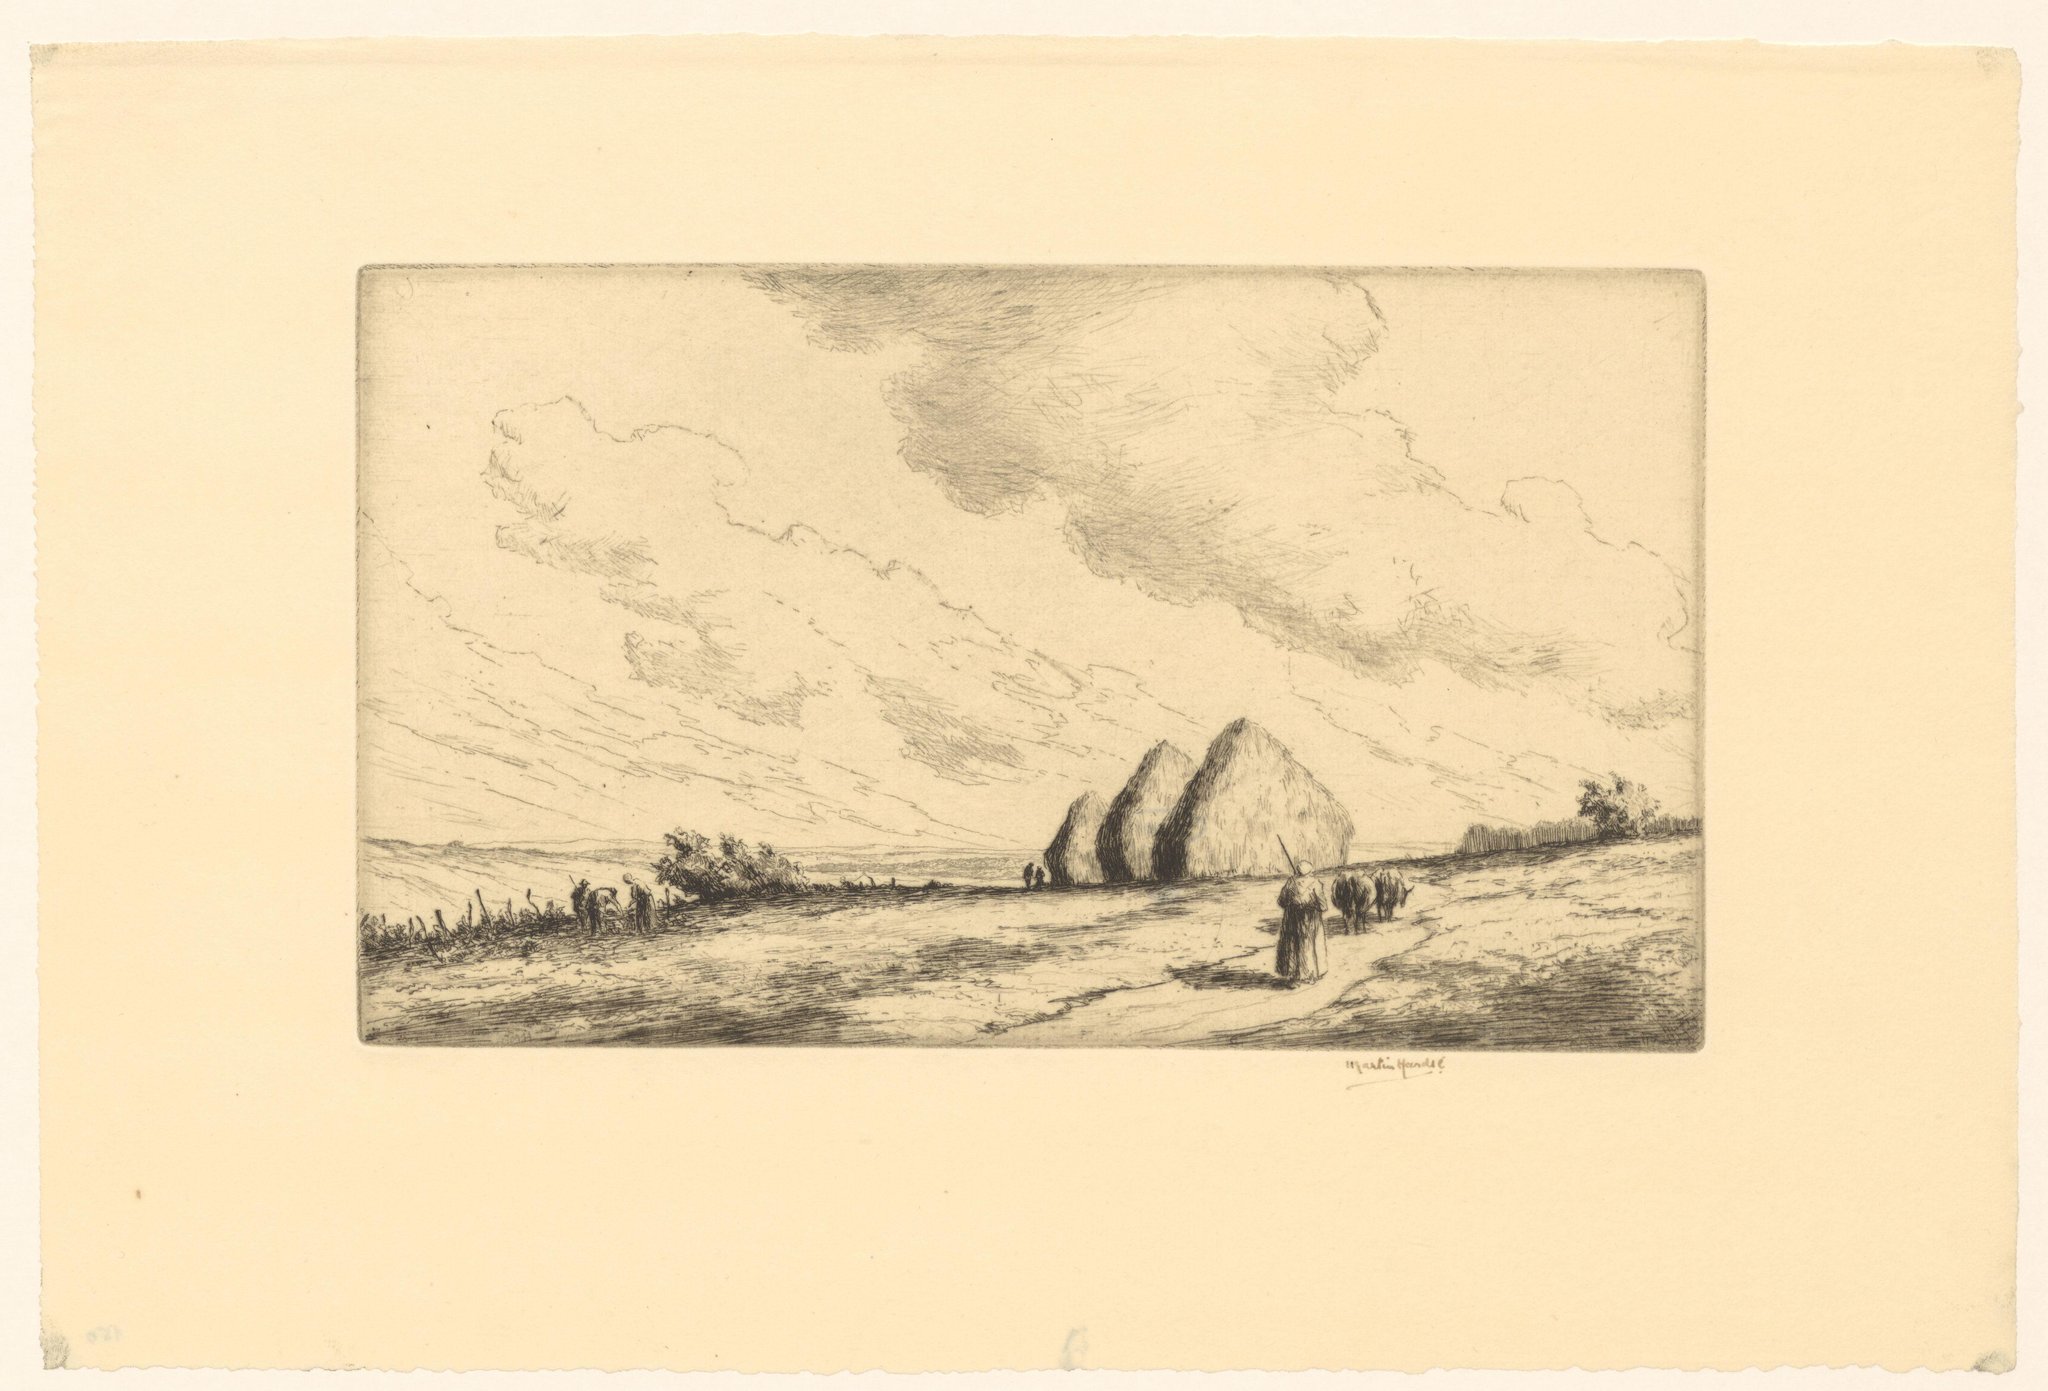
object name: print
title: Belgian Uplands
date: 1932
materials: paper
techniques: etching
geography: houffalize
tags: hay-stack, meadow, pasture (+ landscape with figures, staffage), piling up ~ harvest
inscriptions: collector's mark: Lugt 2760, collector's mark: Lugt 2228, annotation: ‘Martin Hardie’